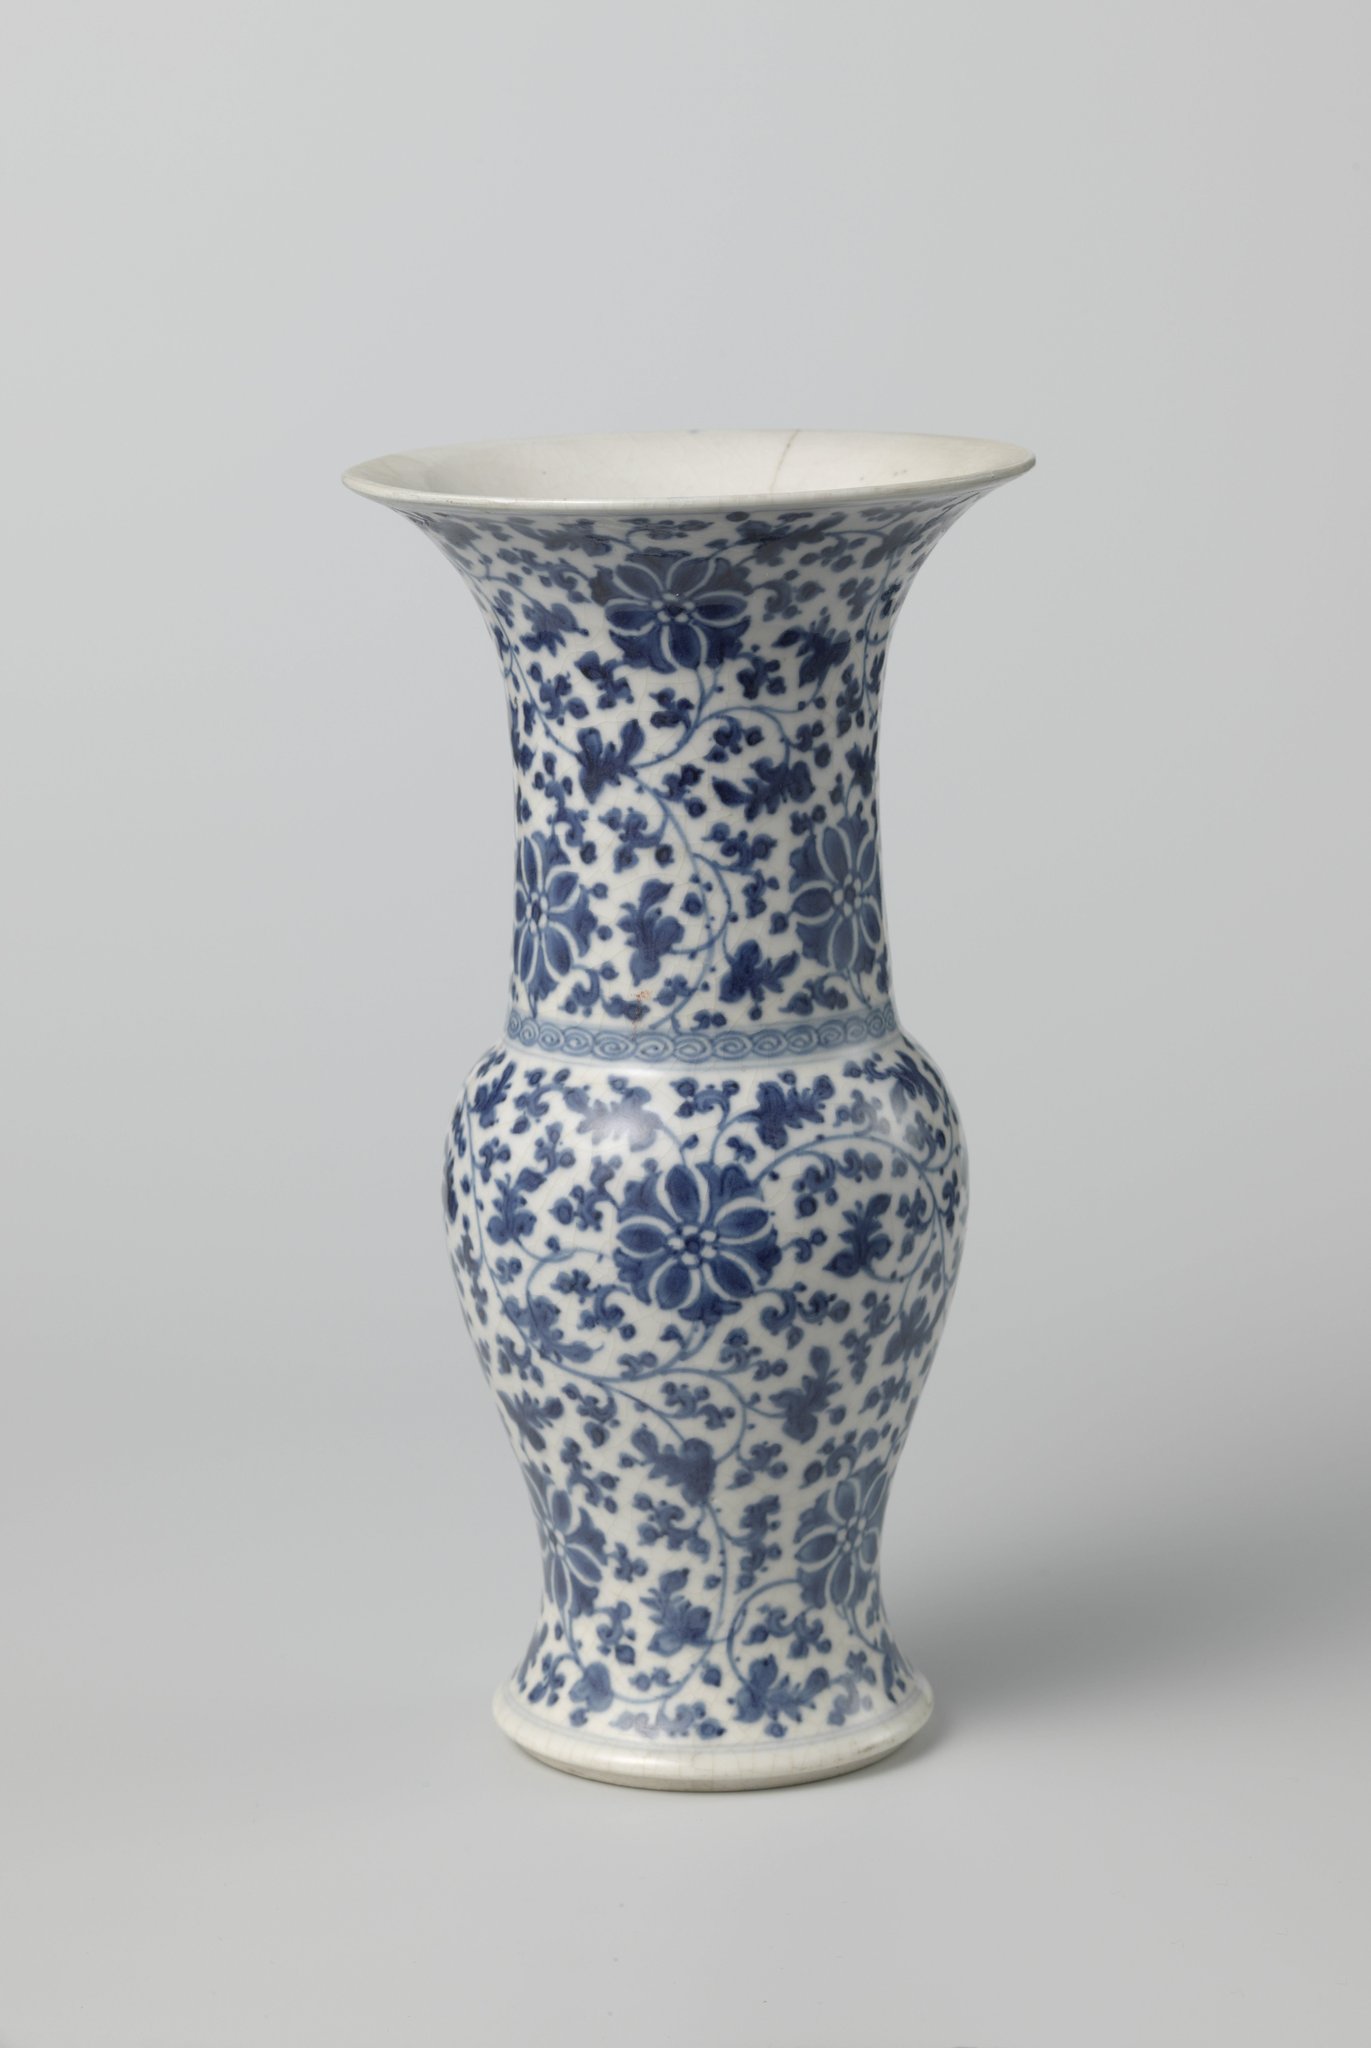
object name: vase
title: Balustervase with stylized flower pattern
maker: Anonymous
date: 1800-1899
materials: cobalt, glaze, paint, porcelain, soft paste porcelain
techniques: firing, turning, vitrification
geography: china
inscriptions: mark: ‘成 化 年 製’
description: Balustervormige vaas van soft-paste porselein (pâte tendre) met brede, recht nek en trompetvormige mond, beschilderd in onderglazuur blauw. De vaas is bedekt met gestileerde bloemranken; om de basis van de nek een band met spiraalvormen. Gemerkt op de bodem met het vier-karaktermerk van keizer Chenghua. De rand is gebroken geweest. Blauw-wit.